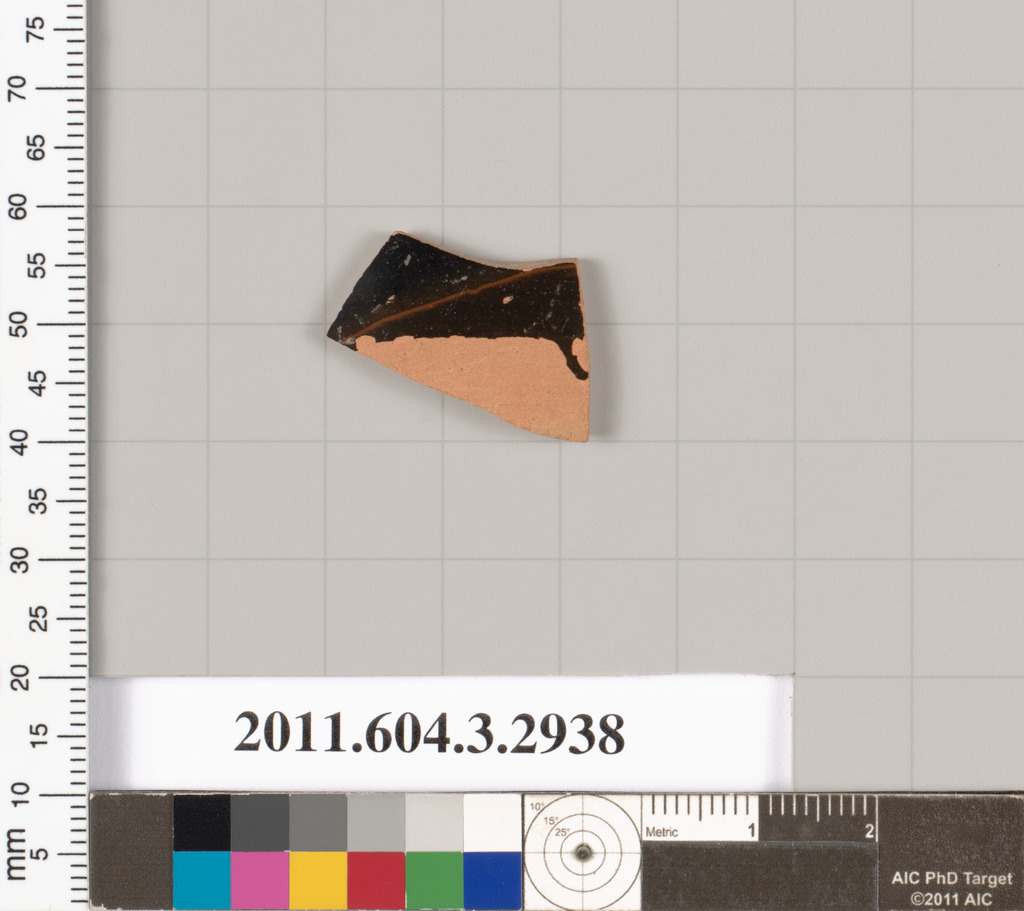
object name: undetermined shape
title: Terracotta fragment of an undetermined shape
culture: greek, attic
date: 600-401 BCE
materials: terracotta